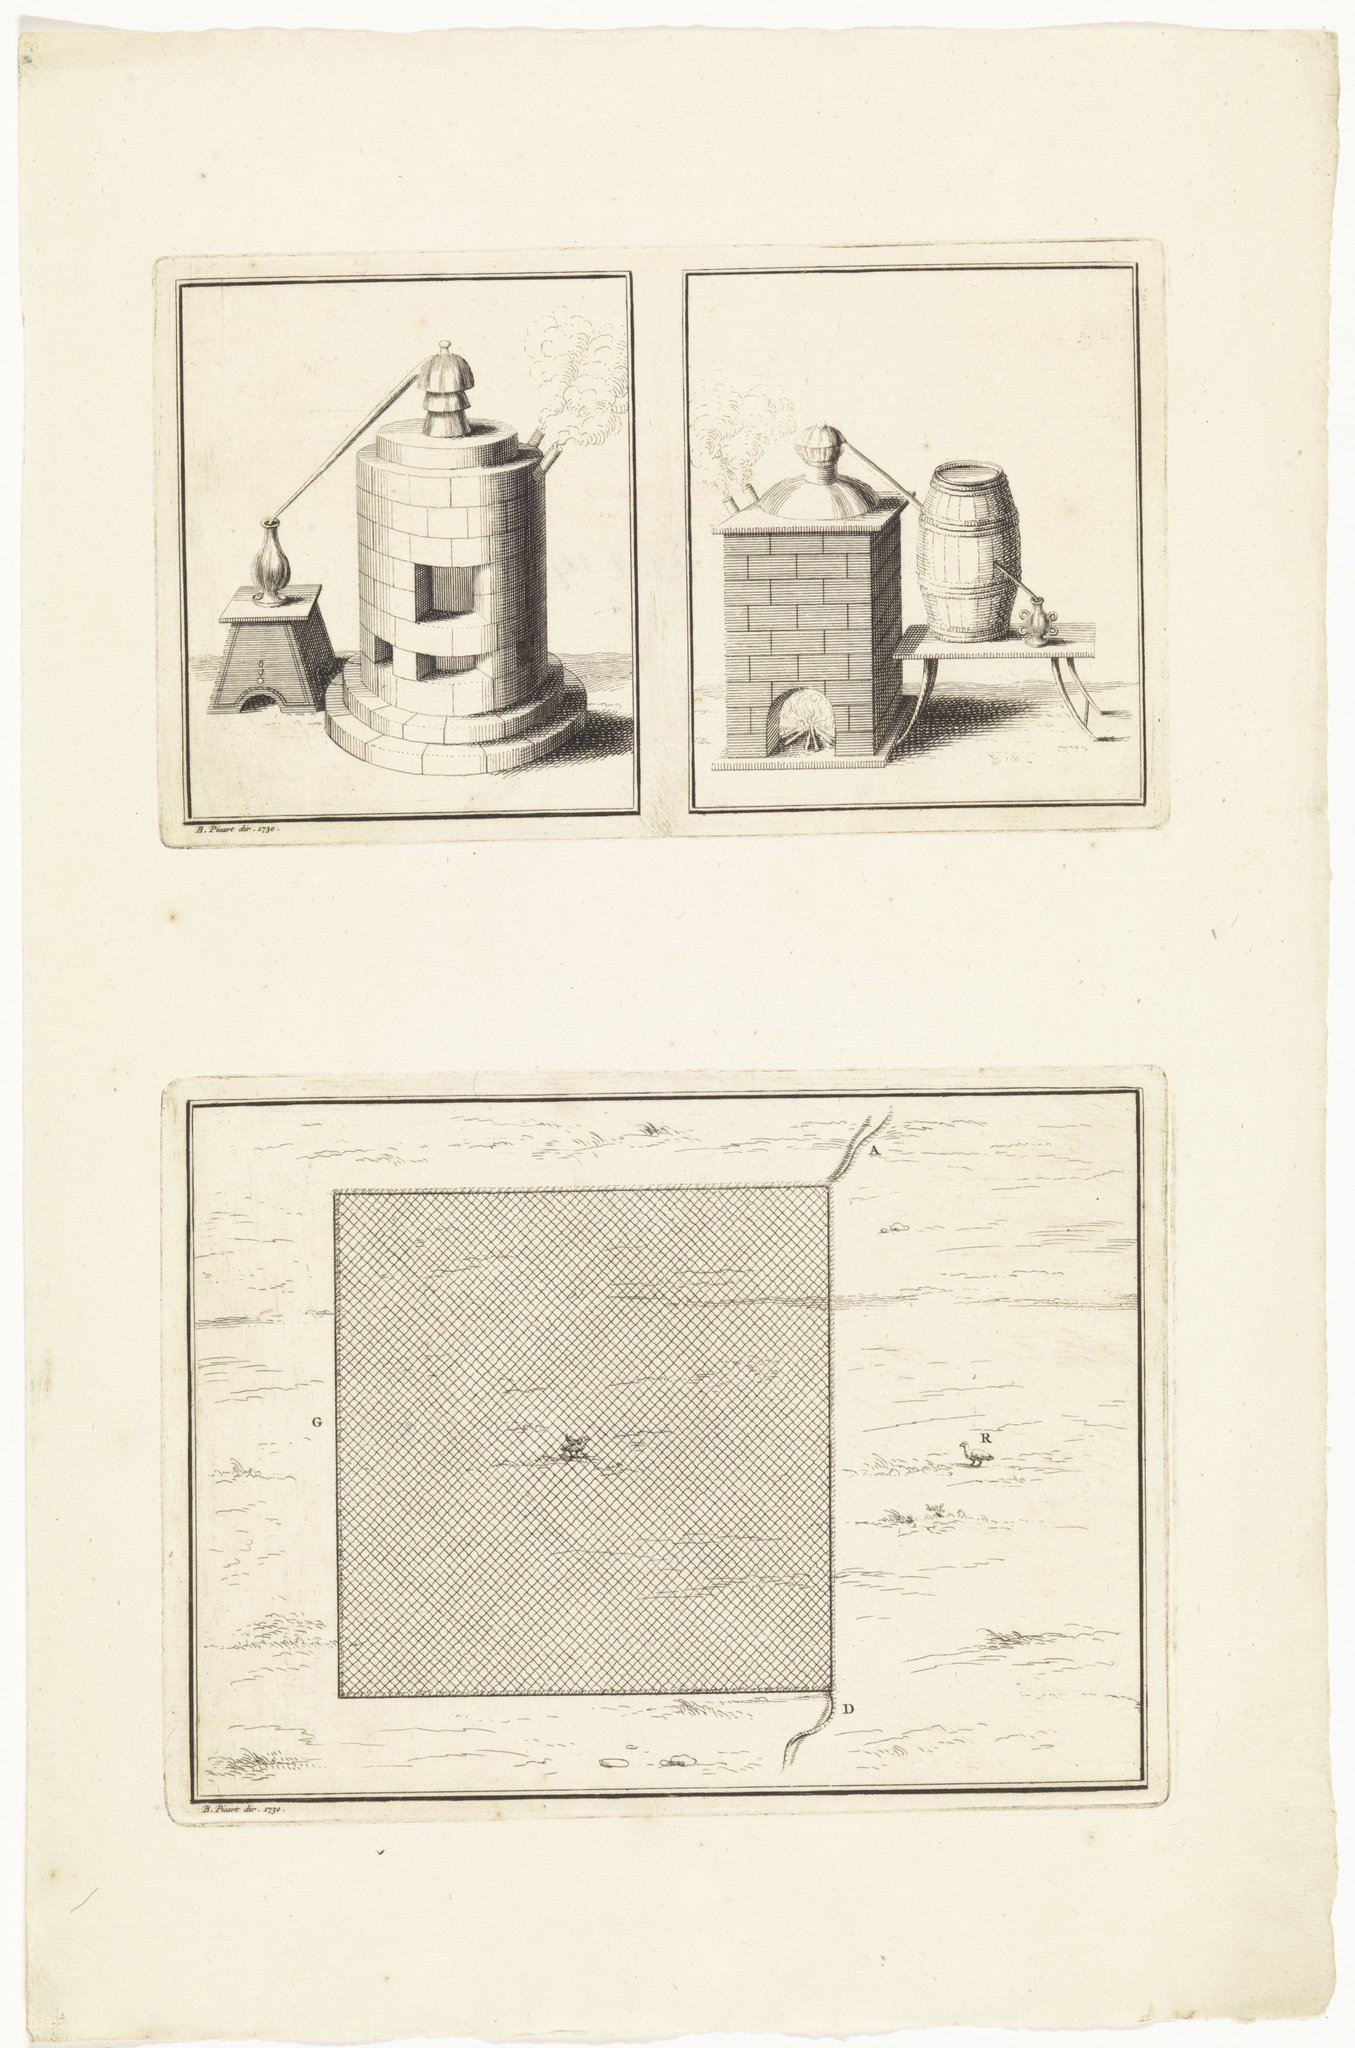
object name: book illustration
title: Destilleerapparaten en een net om vogels te vangen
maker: bernard picart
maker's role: draughtsman, print maker, publisher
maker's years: 1673-1733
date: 1730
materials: paper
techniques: etching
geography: amsterdam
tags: catching animals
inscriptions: collector's mark: Lugt 2233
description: Prenten bedoeld voor: Chomel, Noel. Dictionnaire oeconomique, contenant divers moïens d'augmenter son bien, et de conserver sa santé. Amsterdam: Johannes Covens en Cornelis Mortier, 1732.